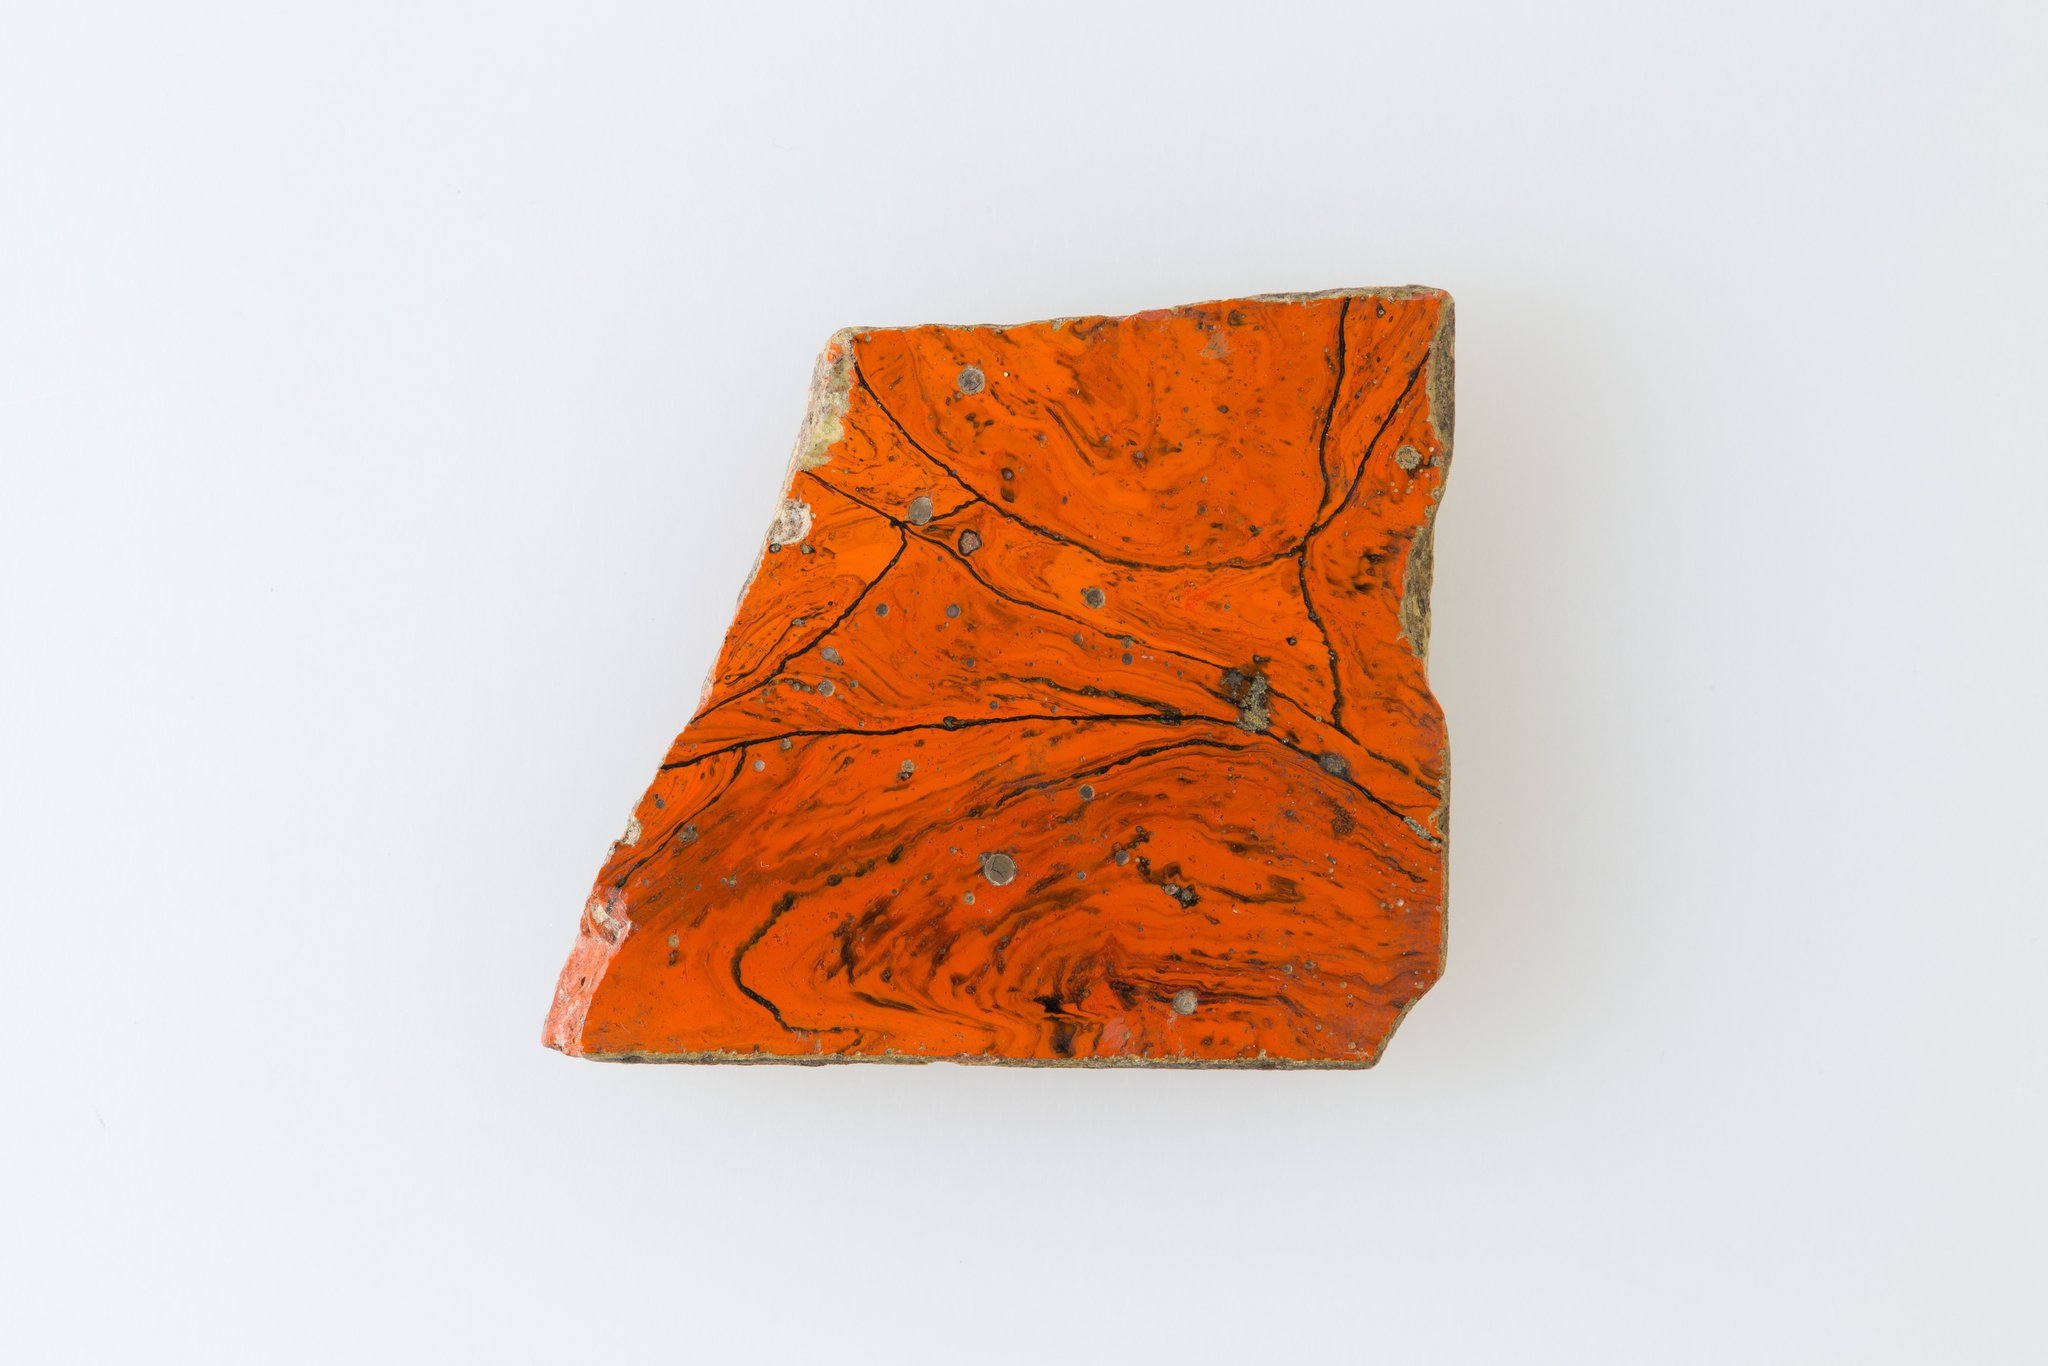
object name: wall revetment fragment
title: Wall revetment fragment, marbled pattern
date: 100 BCE-100 CE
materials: glass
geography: egypt